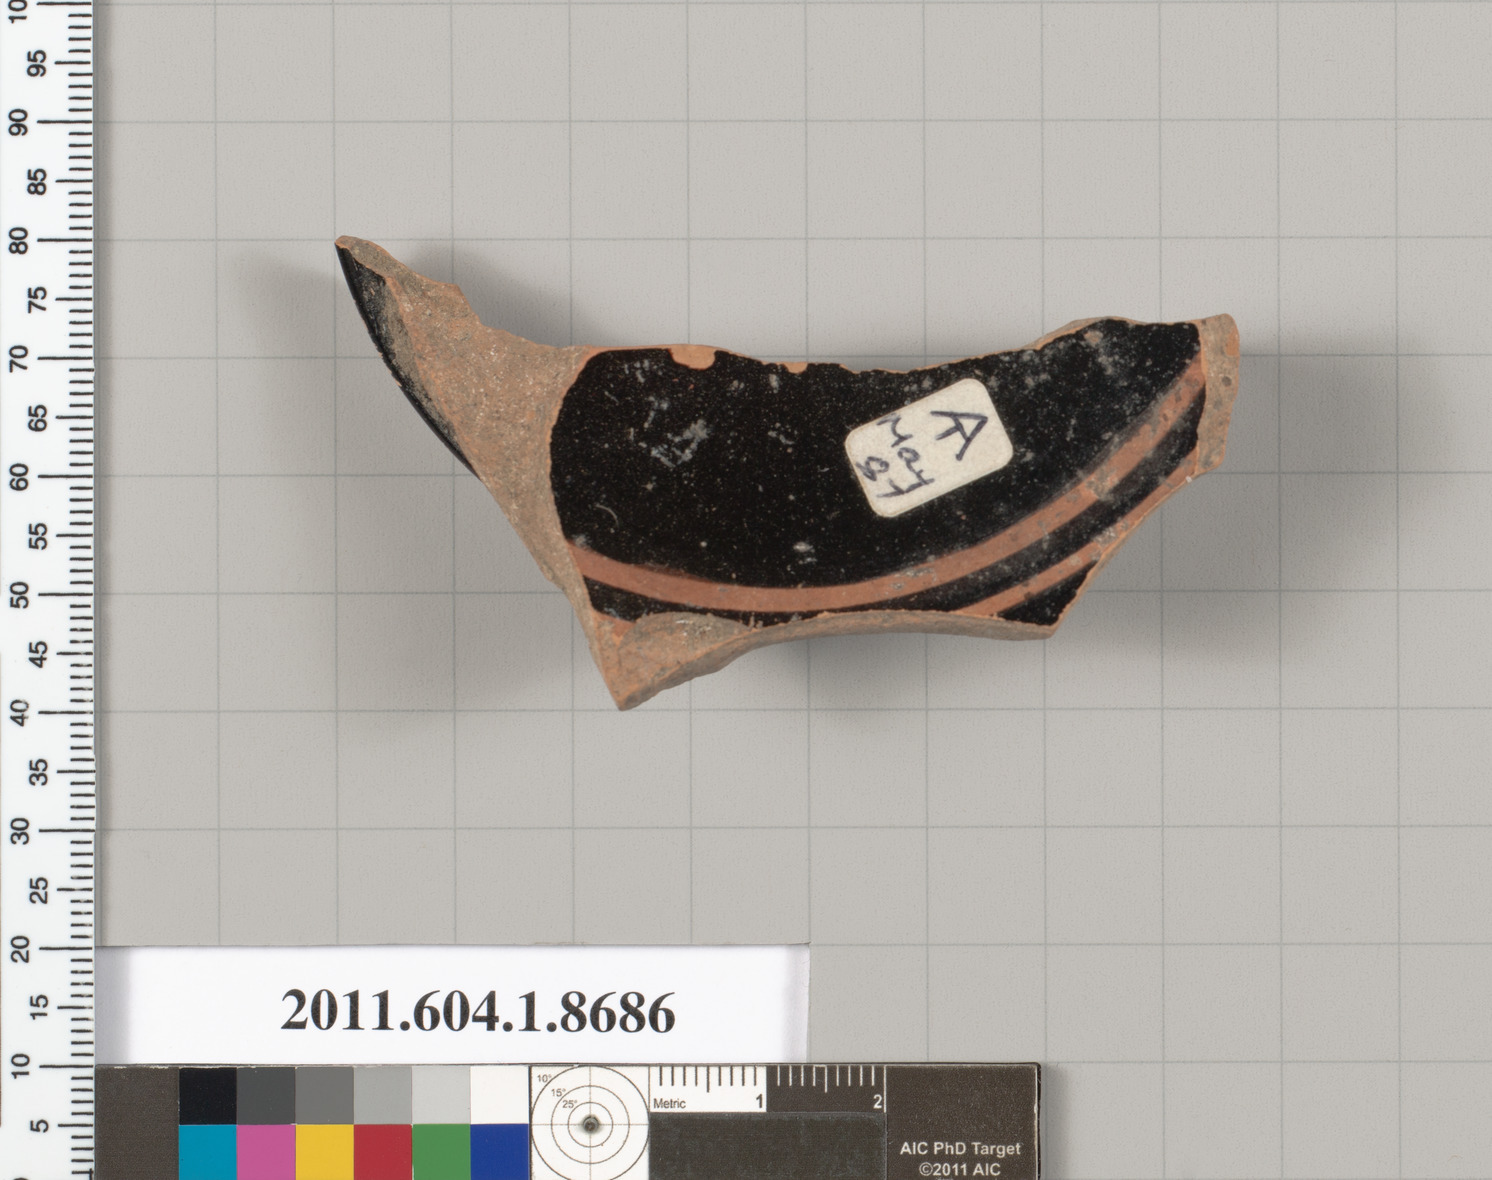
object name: kylix fragment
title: Terracotta fragment of a stemless kylix (drinking cup)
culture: greek, attic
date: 467-435 BCE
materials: terracotta